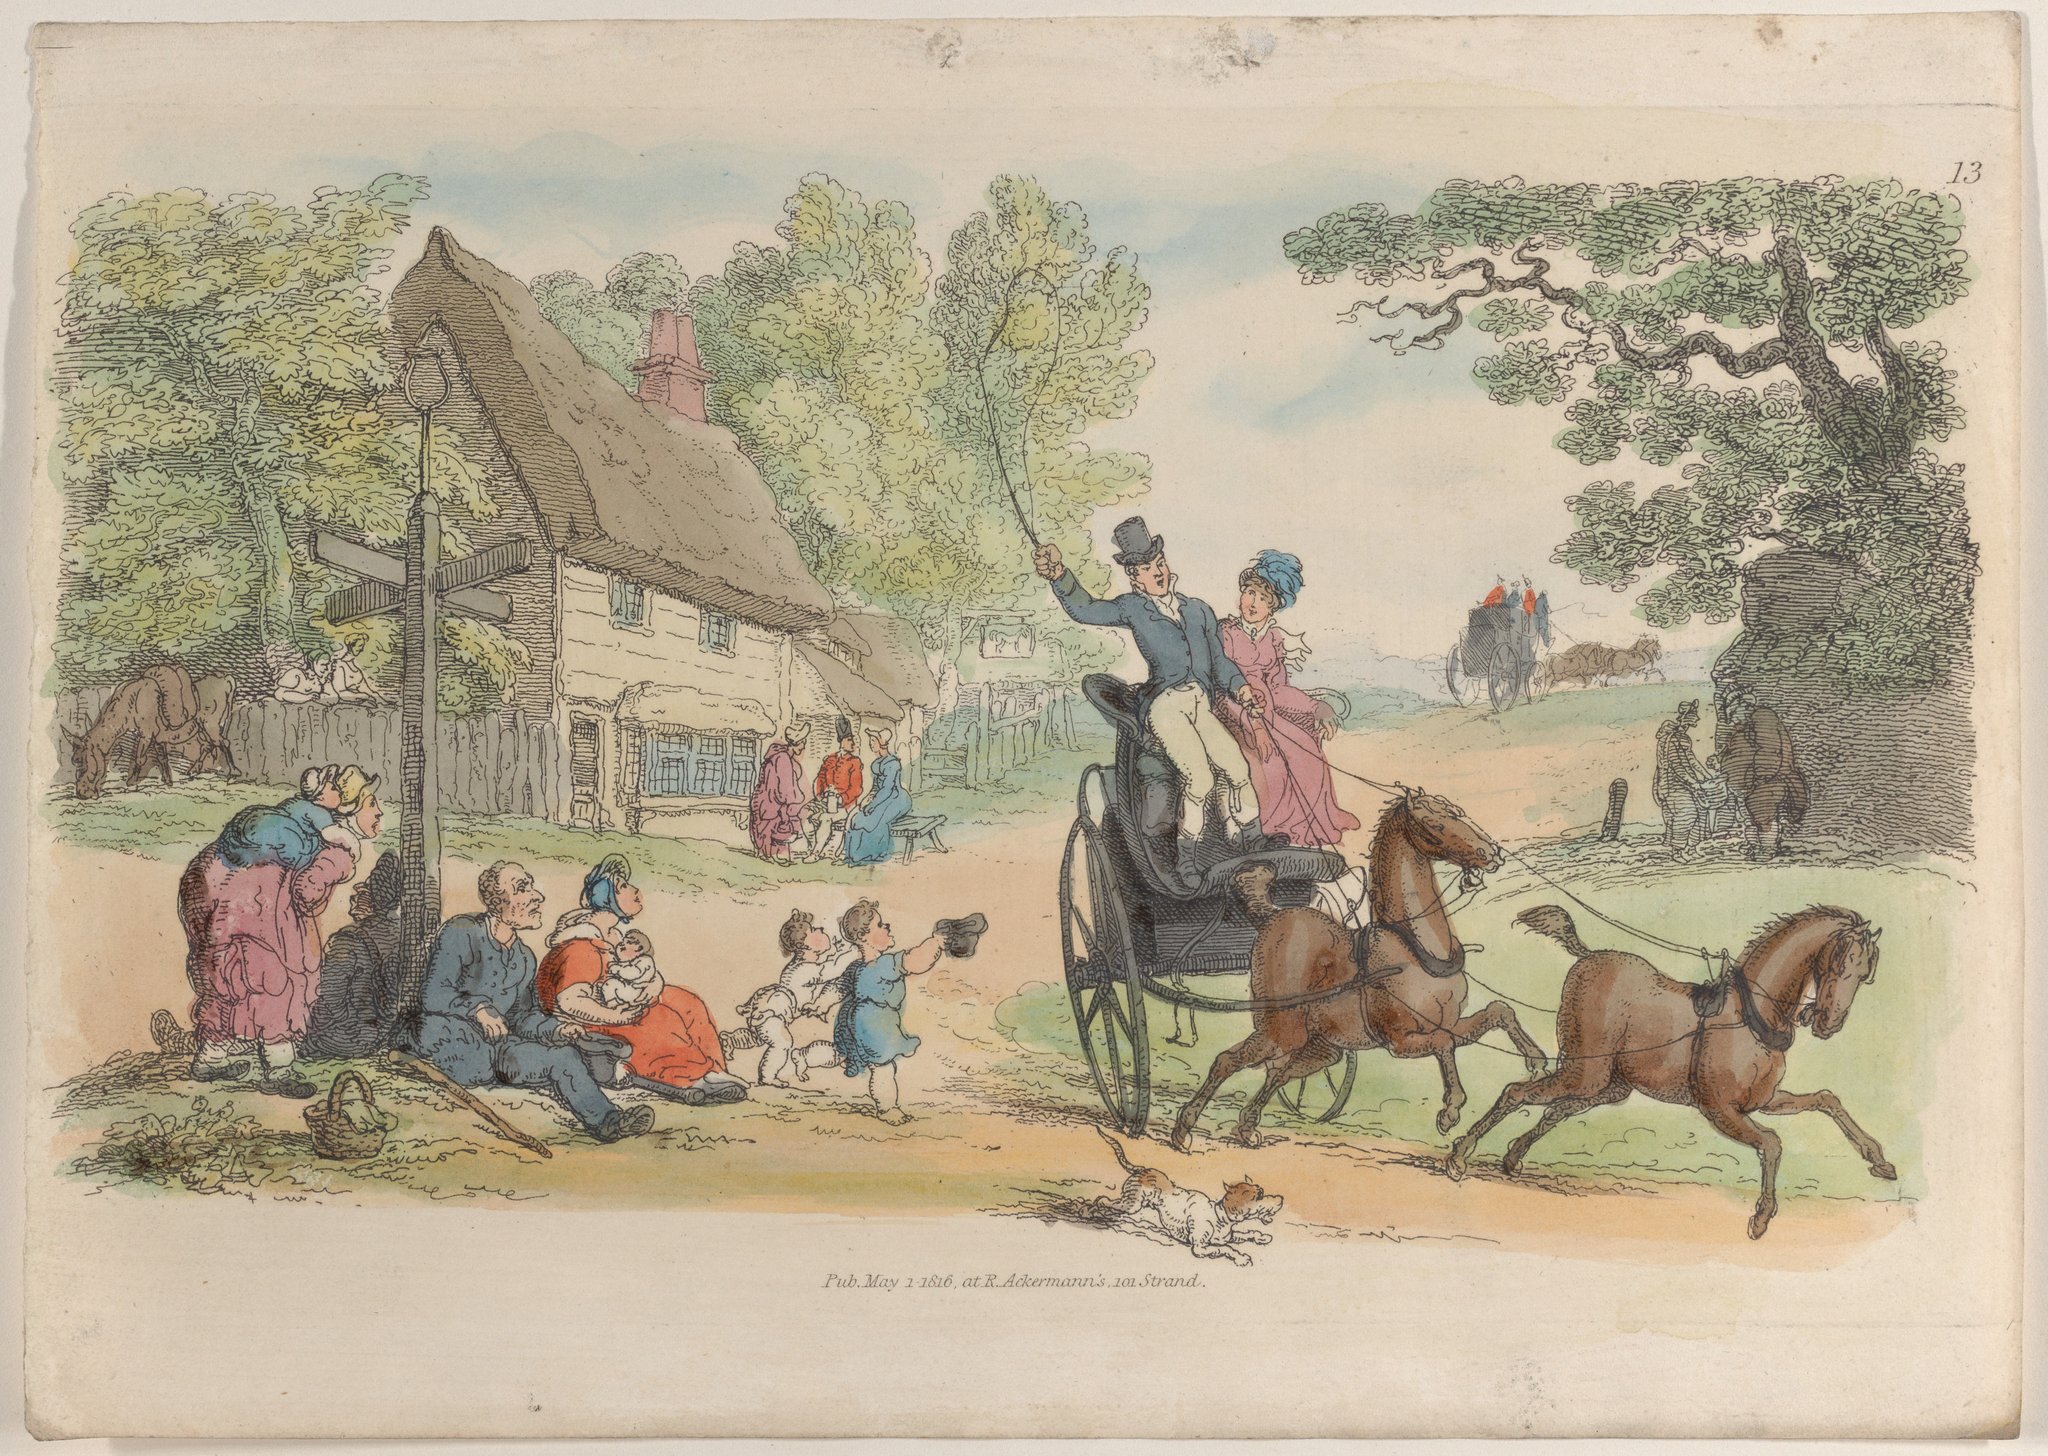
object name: print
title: Plate 13, from "World in Miniature"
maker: thomas rowlandson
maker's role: artist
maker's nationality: british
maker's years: 1757-1827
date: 1816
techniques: etching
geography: london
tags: children,men,women,horses,carriages